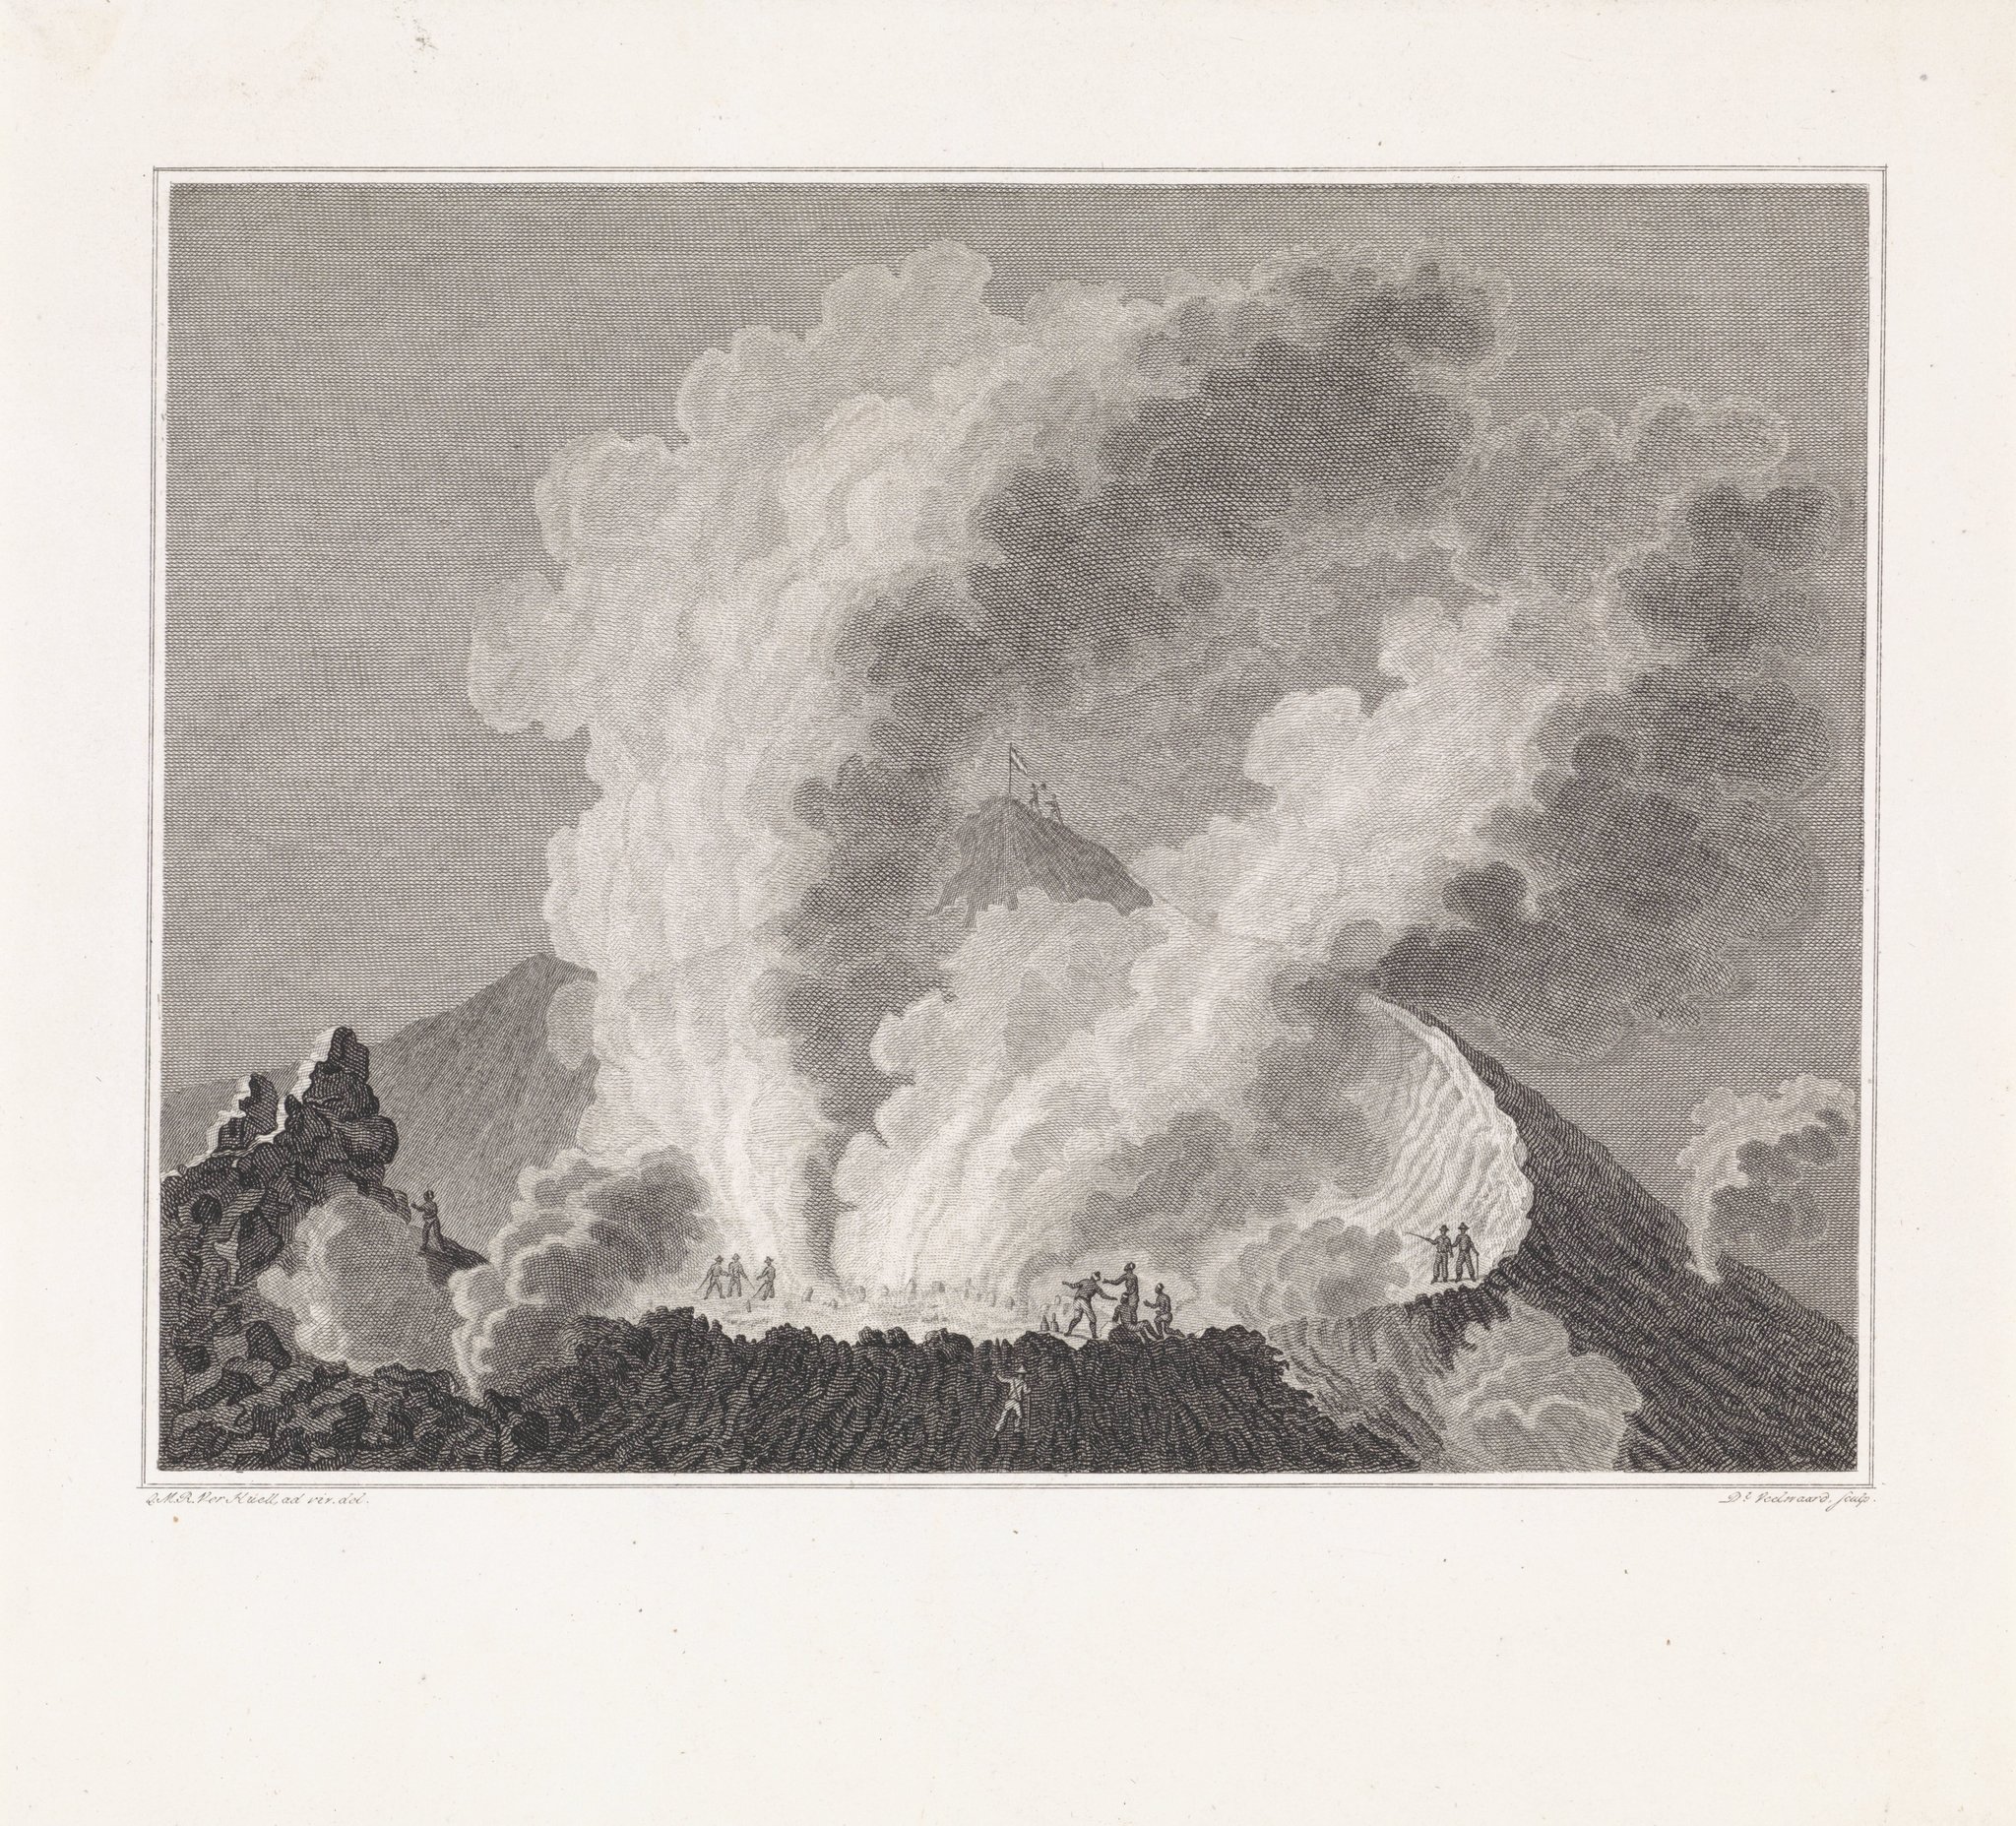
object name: print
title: Figuren in de krater van een vulkaan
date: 1776-1851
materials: paper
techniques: engraving, etching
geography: amsterdam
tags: volcano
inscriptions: collector's mark: Lugt 2228